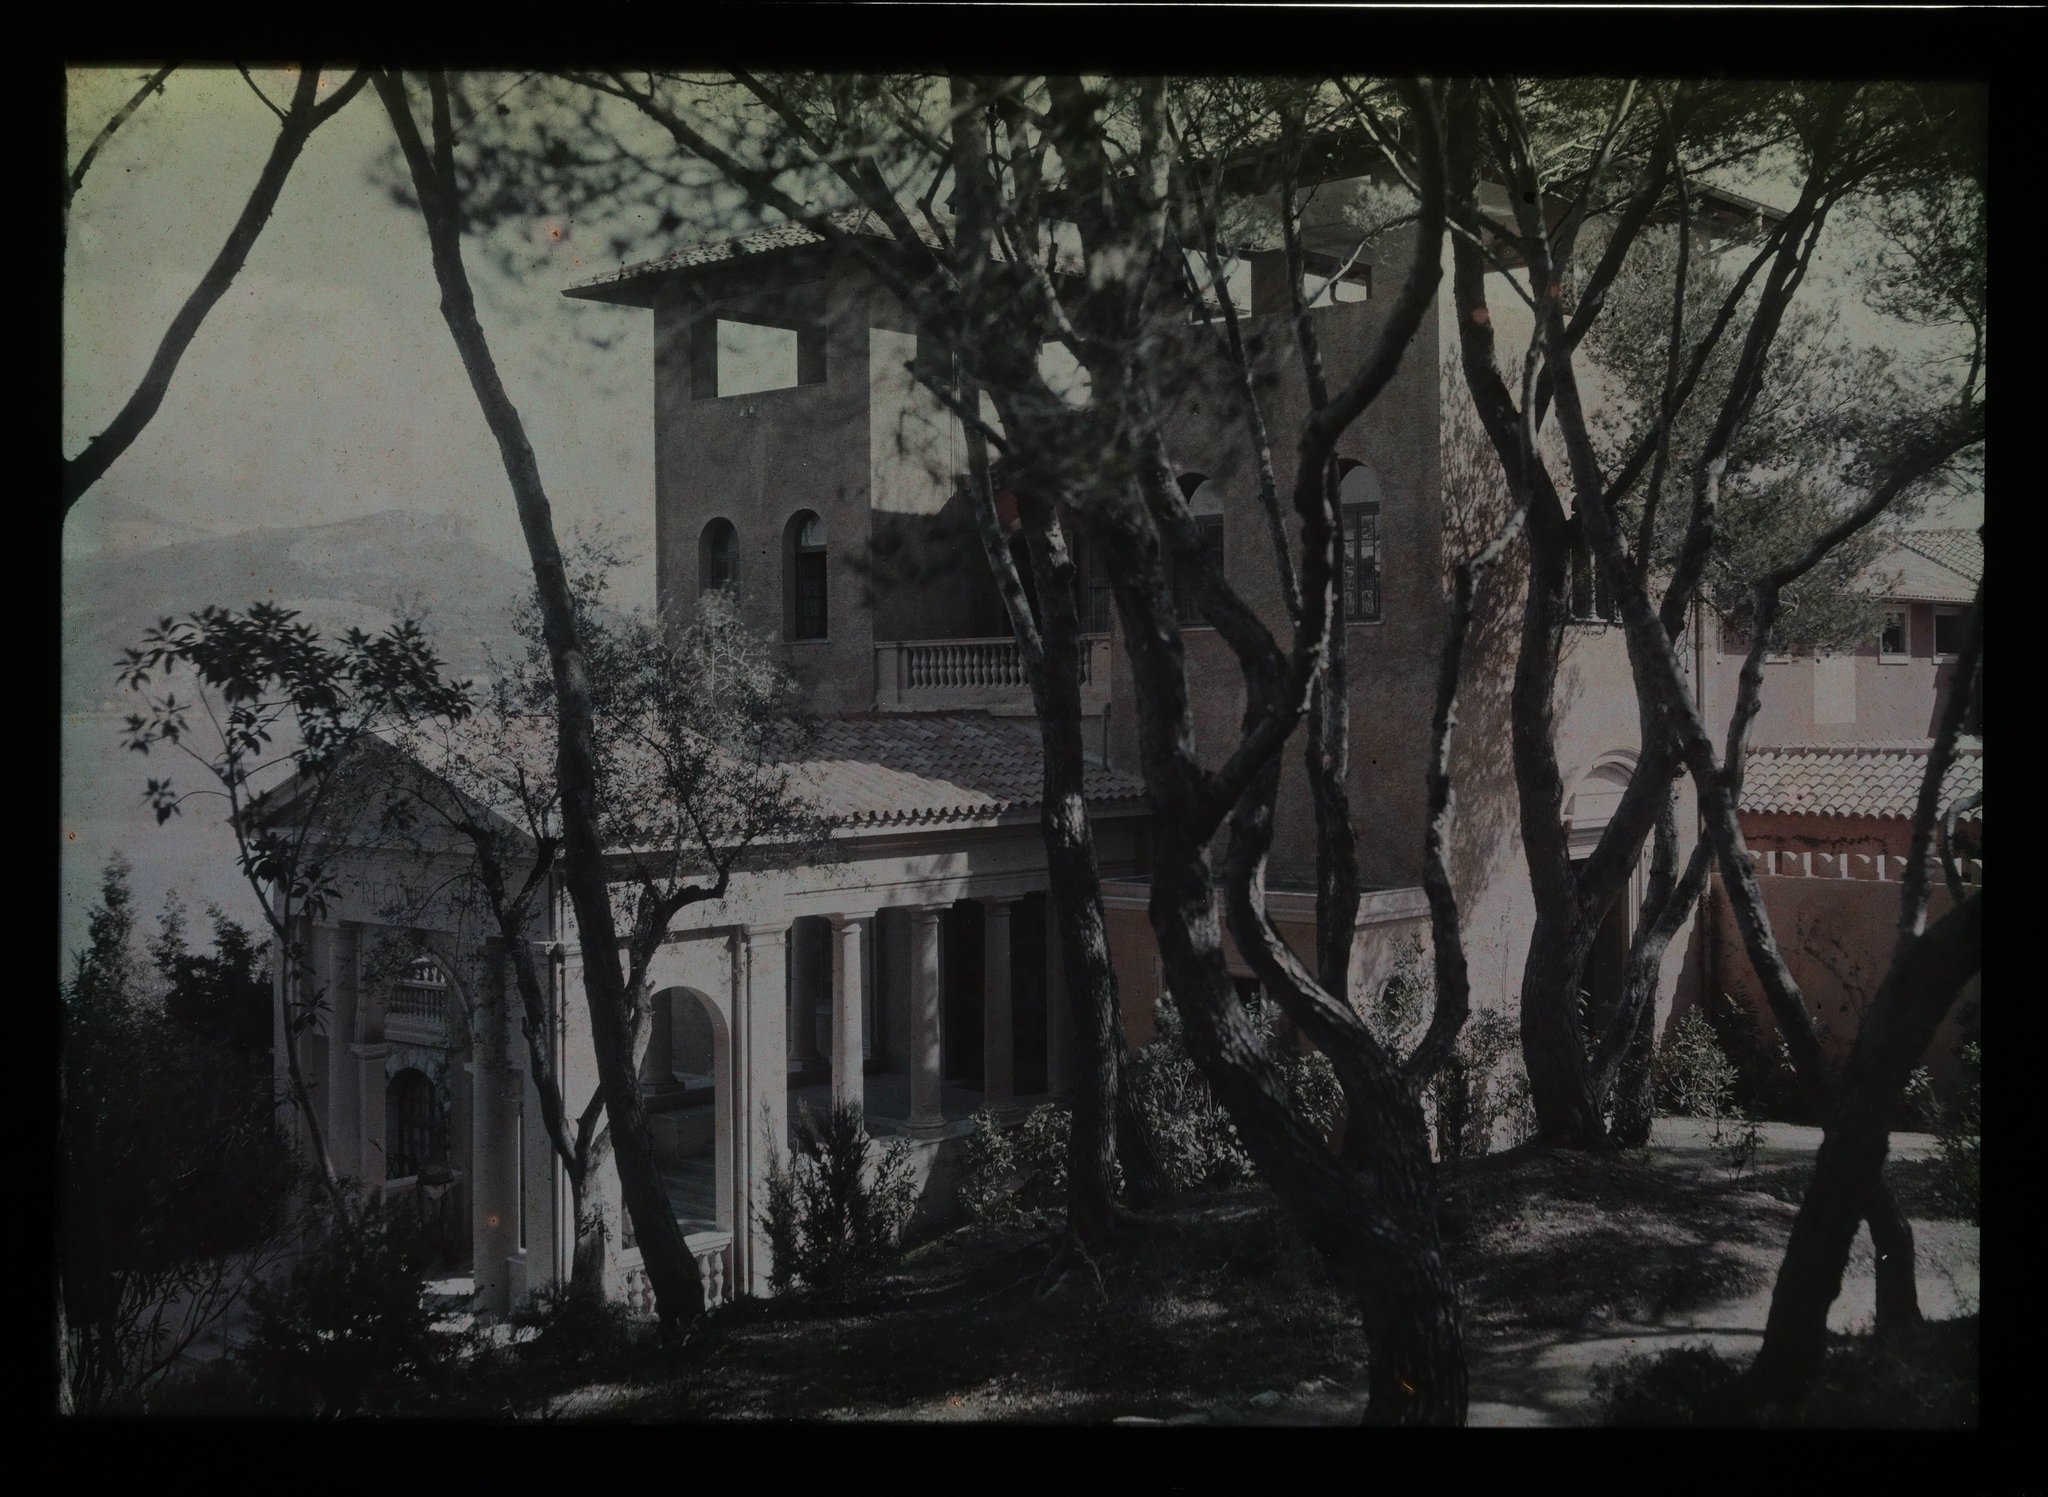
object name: photograph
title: Gedeelte van een roze gepleisterd huis met portico en bomen op de voorgrond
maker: Anonymous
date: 1910-1940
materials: glass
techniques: autochrome process